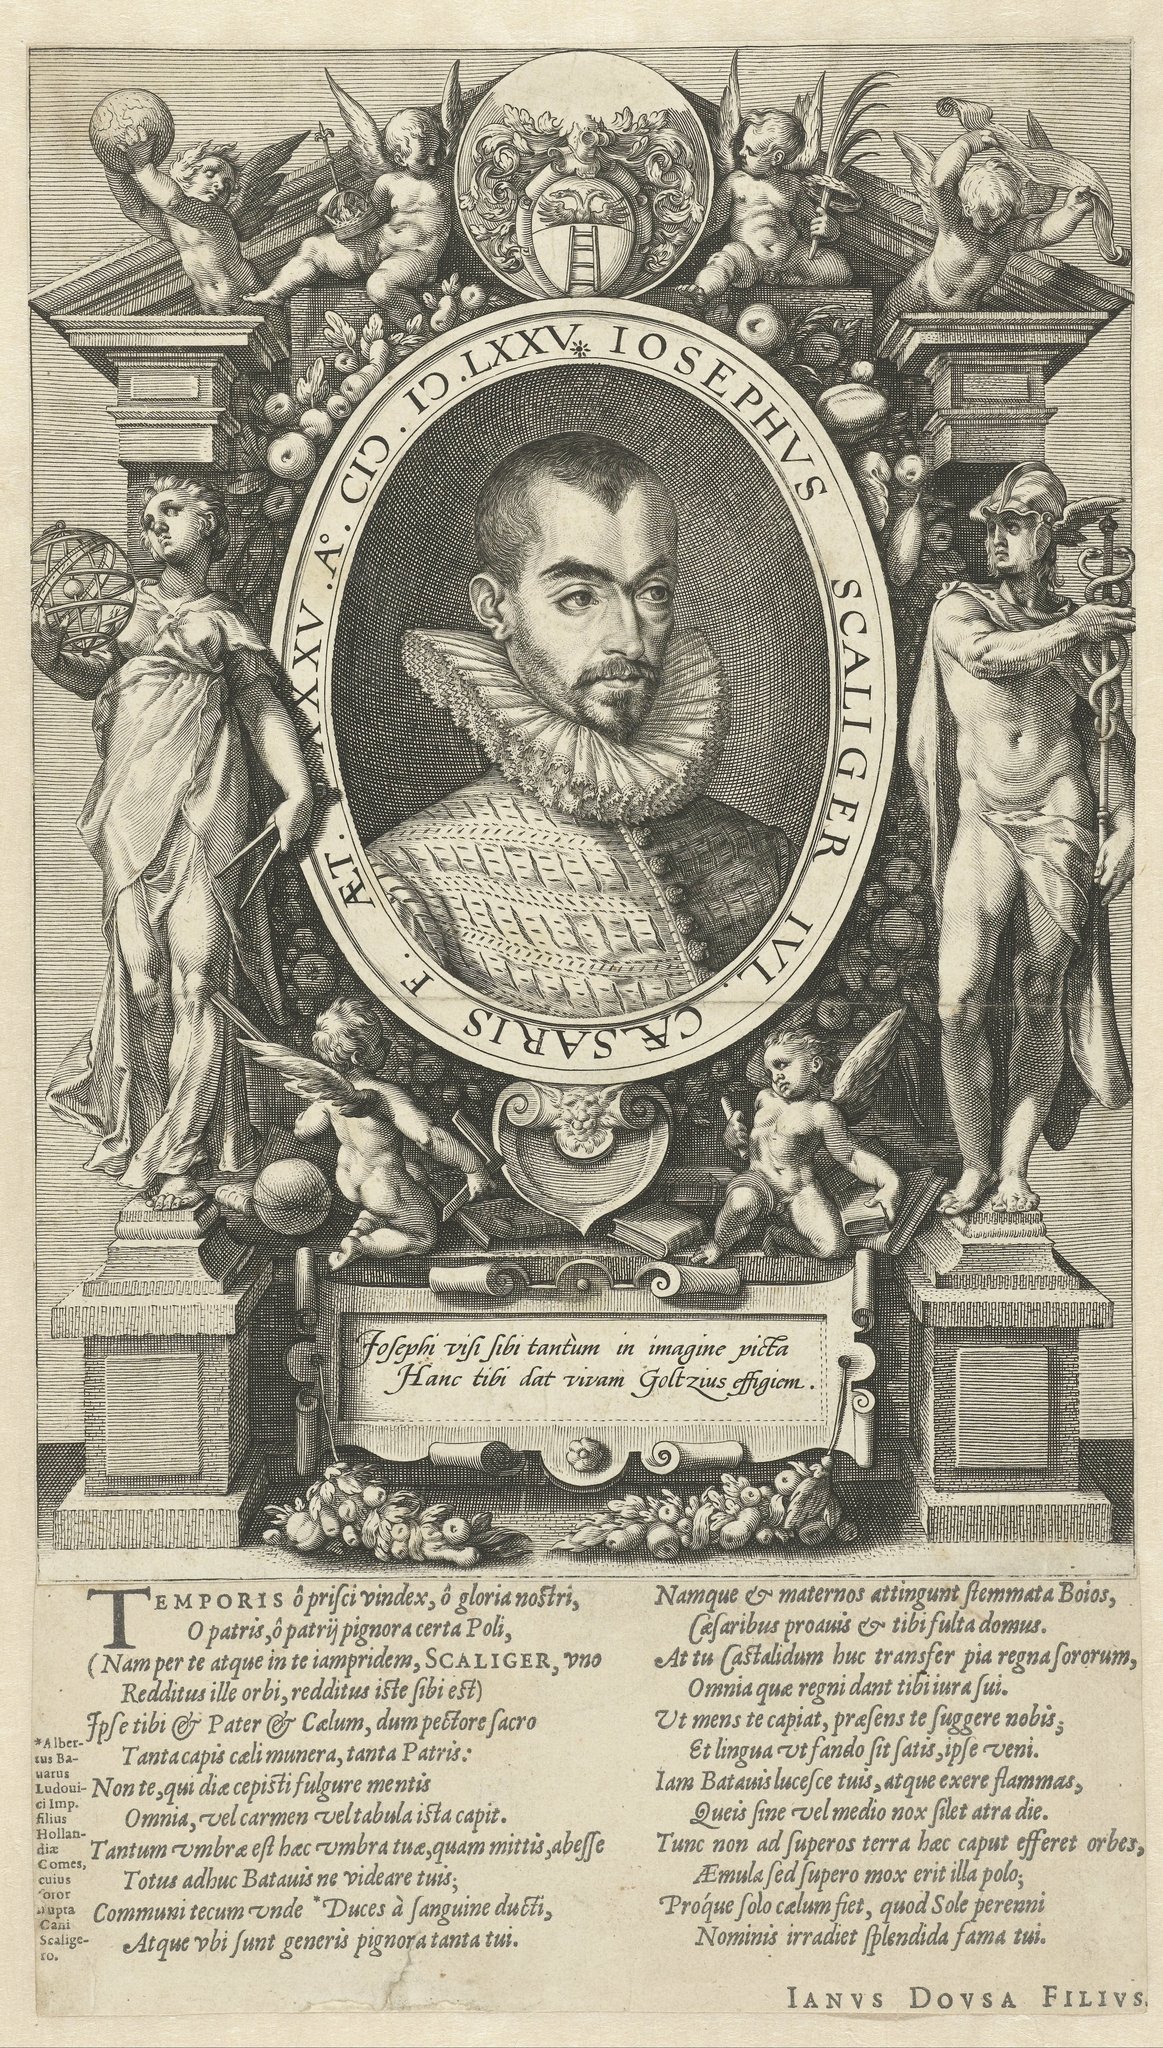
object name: print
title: Portret van Josephus Scaliger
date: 1590-1594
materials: paper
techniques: engraving, letterpress printing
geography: haarlem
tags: philology (+ portrait of scholar, scientist), historical persons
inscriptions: poem: ‘TEMPORIS o prisci vindex...splendida fama tui. Ianus Dousa Filius’, mark: ‘L.2228’, address: ‘...Goltzius effigiem’, title: ‘IOSEPHUS SCALIGER...’, collector's mark: Lugt 240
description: Deze gravure werd samen met Goltzius' gravure van de vader van Josephus Justus Scaliger, Julius Caesar Scaliger (zie nummers/relaties), in opdracht van de Universiteit Leiden vervaardigd in 1592. De universiteit stuurde afdrukken van deze twee prenten naar verschillende geleerden in Europa. Goltzius ontving voor het graveren van de twee platen 200 guldens en nog 11 guldens extra om van elke plaat 500 afdrukken te maken. De platen bevinden zich in de Universiteitsbibliotheek van Leiden. Jacobs, G.